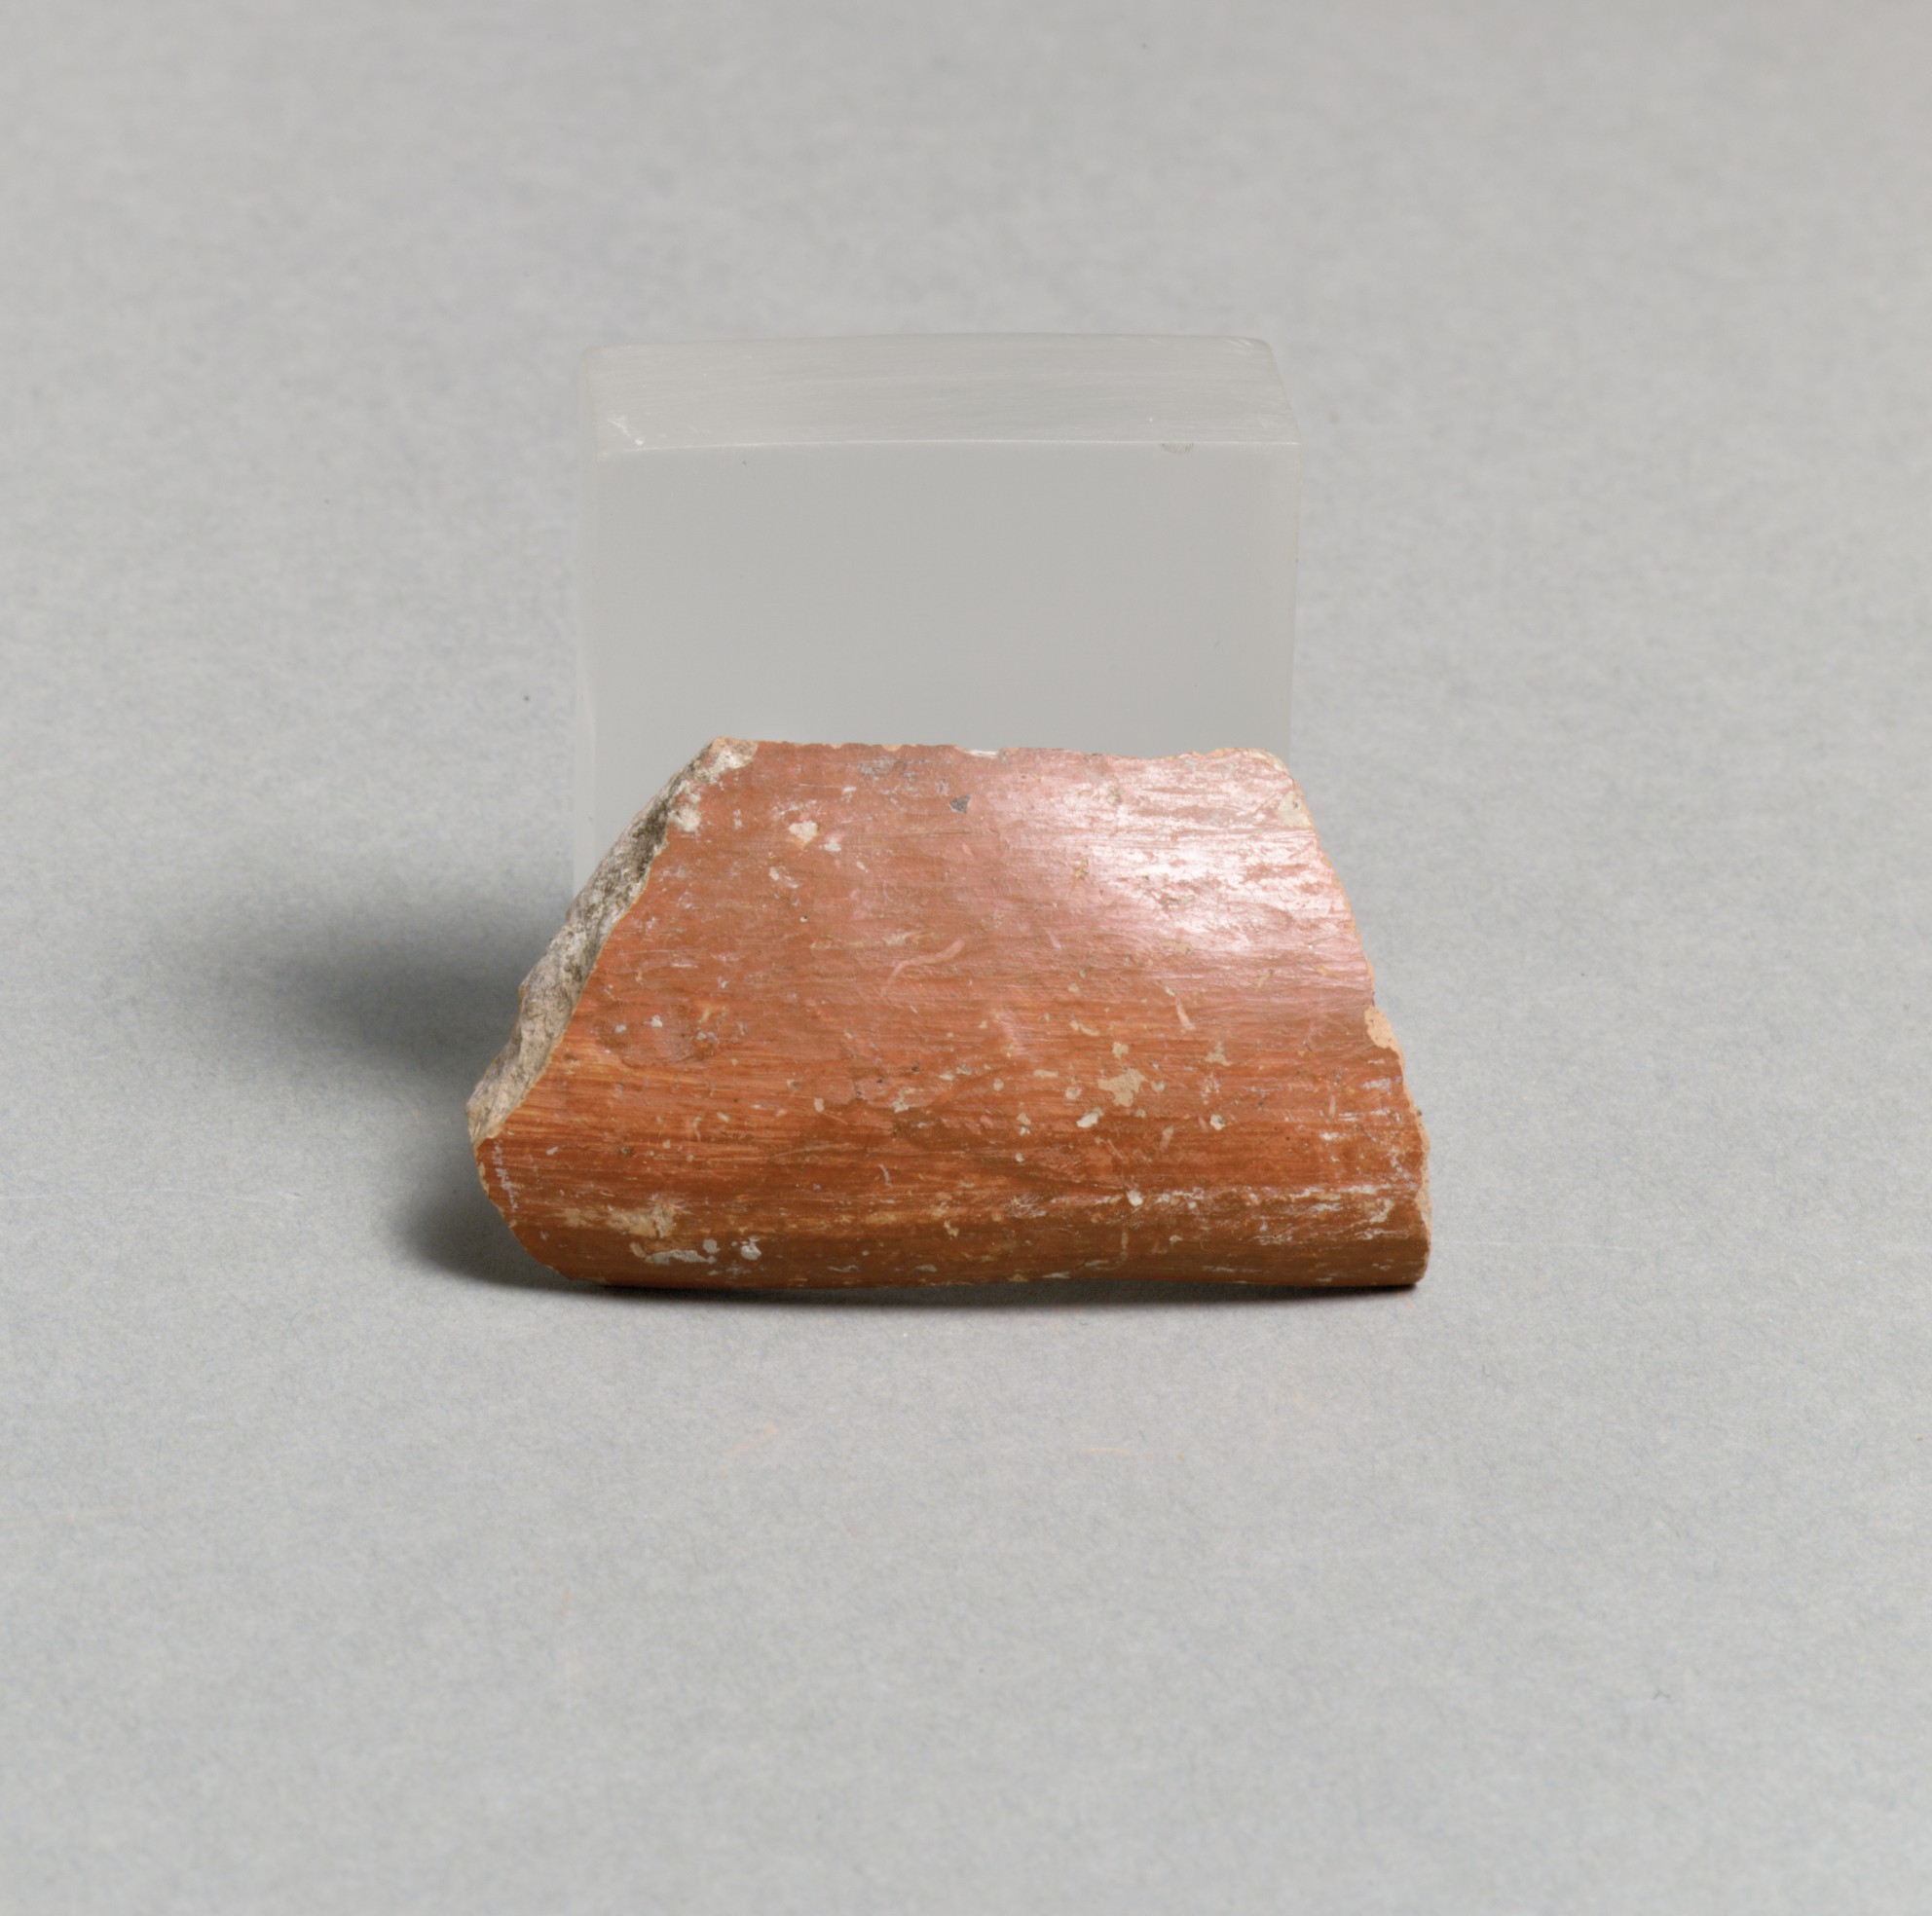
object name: vase fragment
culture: aegean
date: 3000-2000 BCE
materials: terracotta